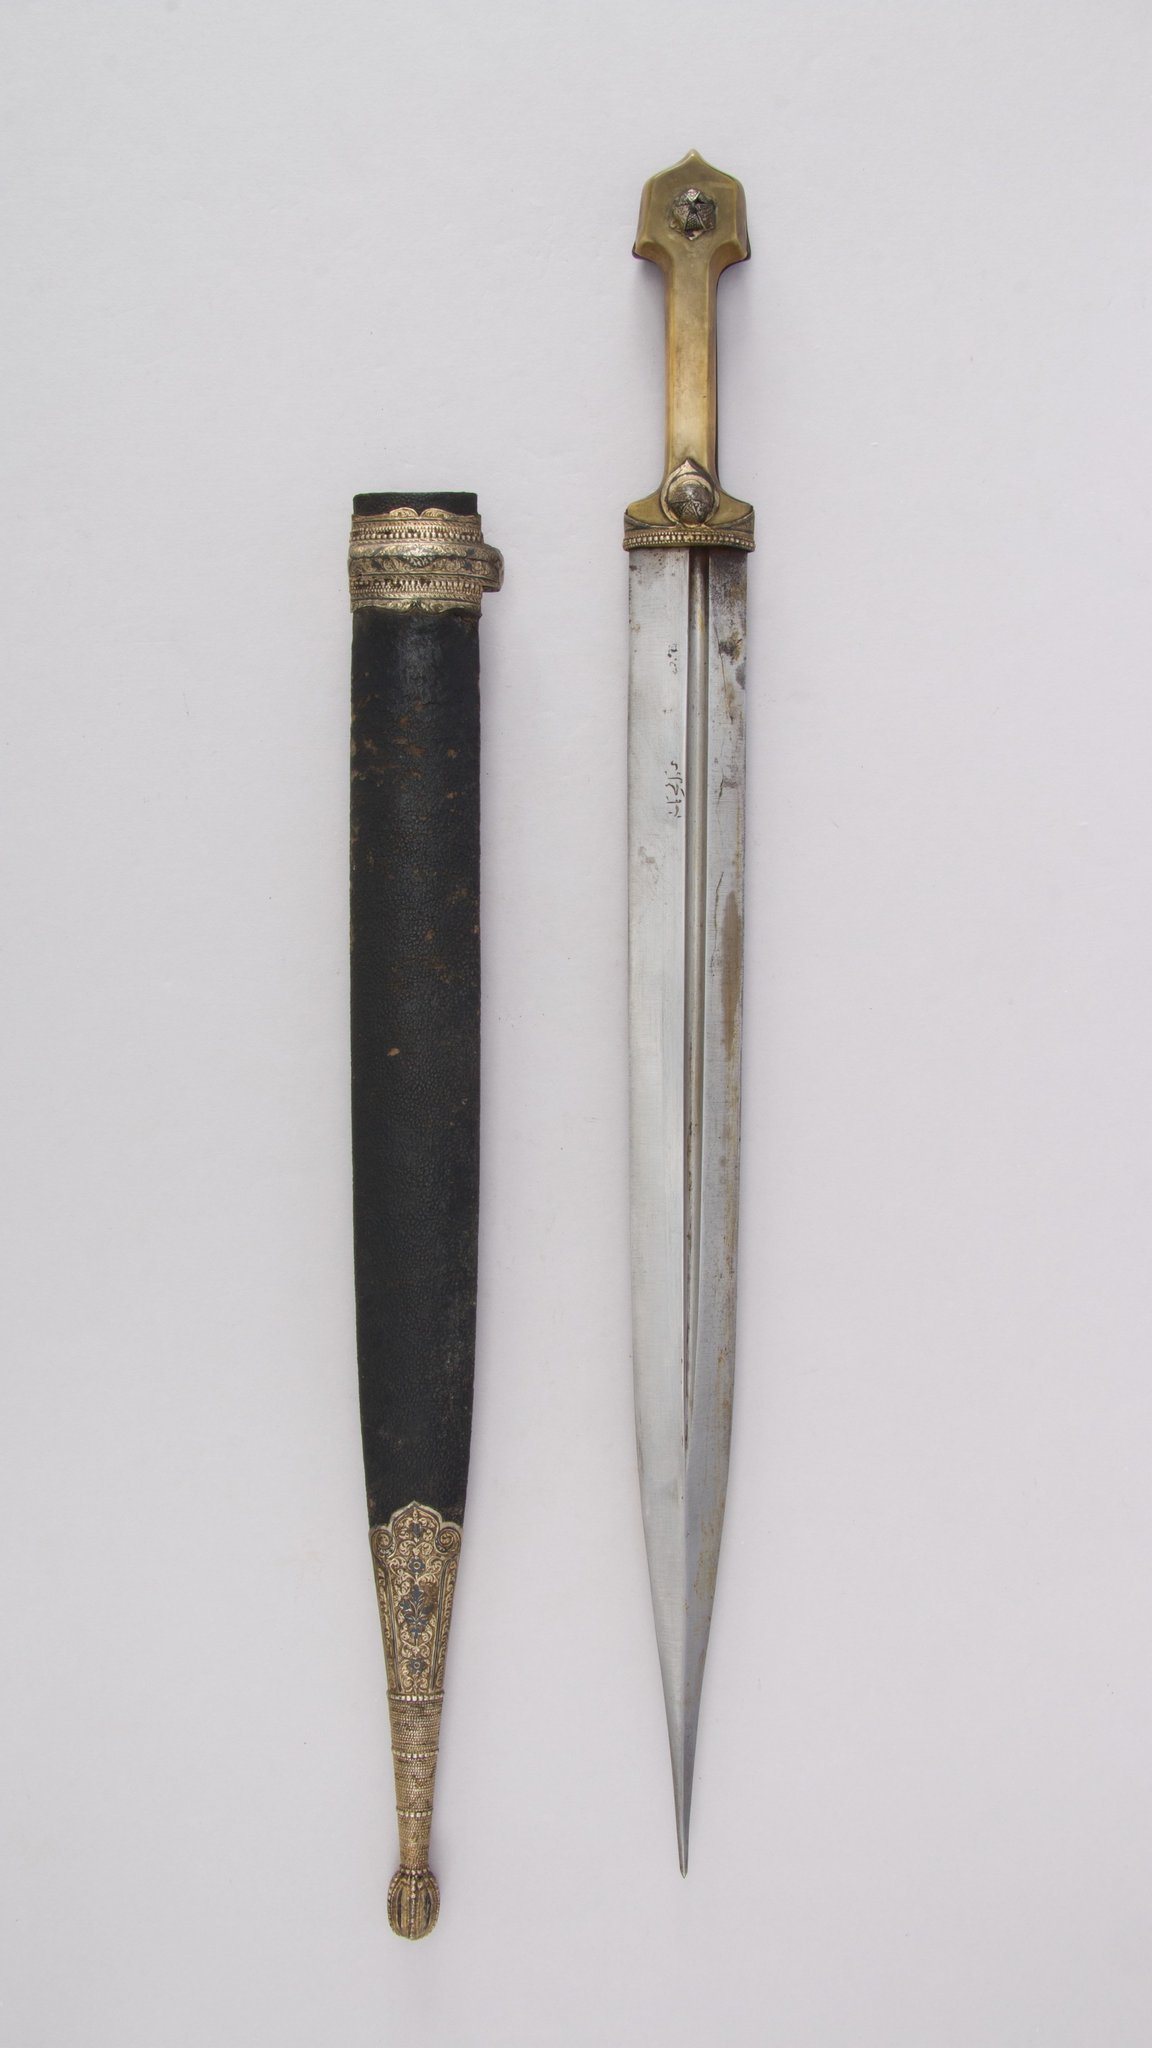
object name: dagger kindjal with sheath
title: Dagger (Kindjal) with Sheath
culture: caucasian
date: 1701-1900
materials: bone, horn, leather, silver, steel, wood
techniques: gilding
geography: caucasus